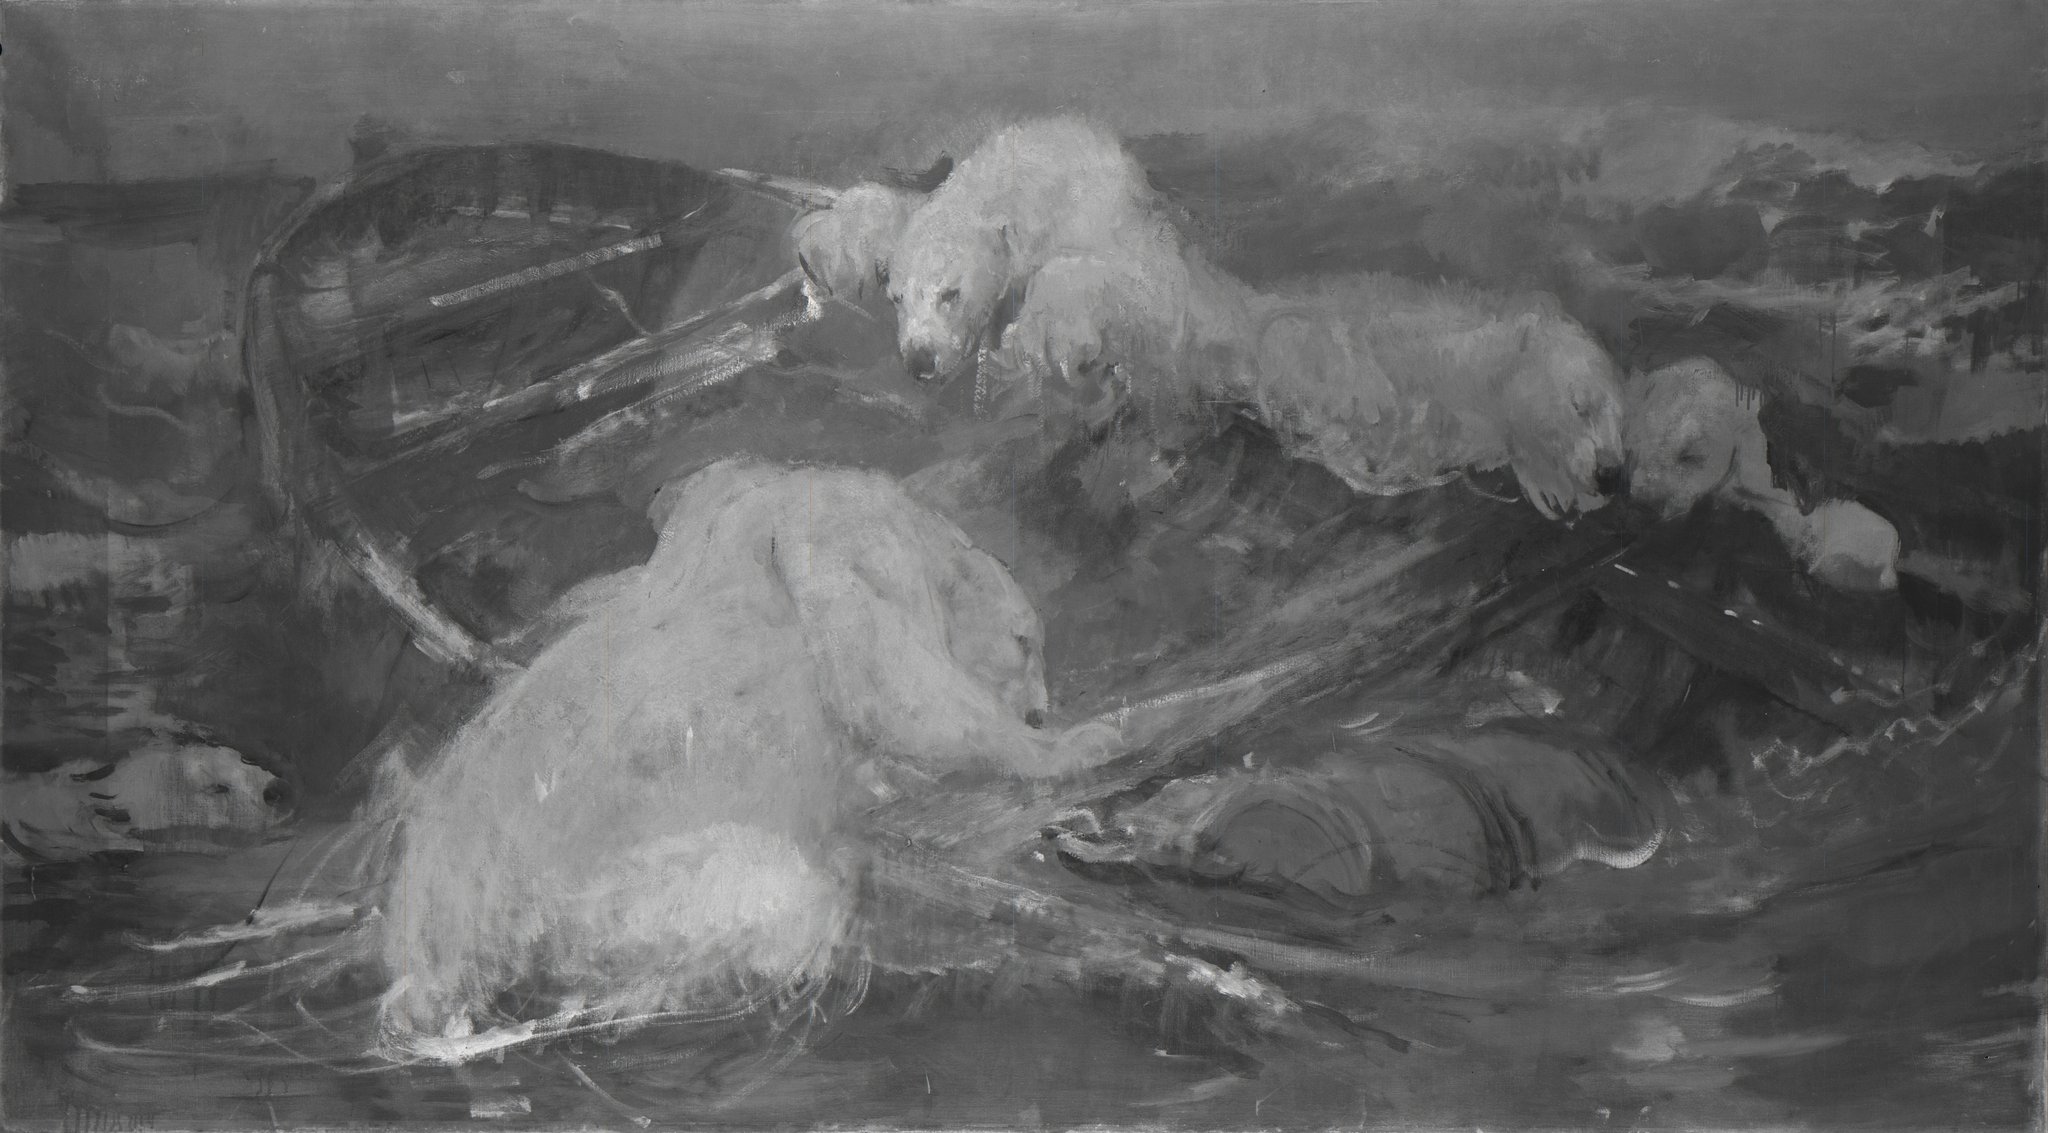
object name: painting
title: IJsberen beklimmen een ronddrijvende sloep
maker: john macallan swan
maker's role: draughtsman, painter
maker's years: 1847-1910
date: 1870-1910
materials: canvas, oil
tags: beasts of prey, predatory animals: polar bear, rowing-boat, canoe, etc.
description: Vier ijsberen beklimmen een in het water ronddrijvende verlaten sloep.